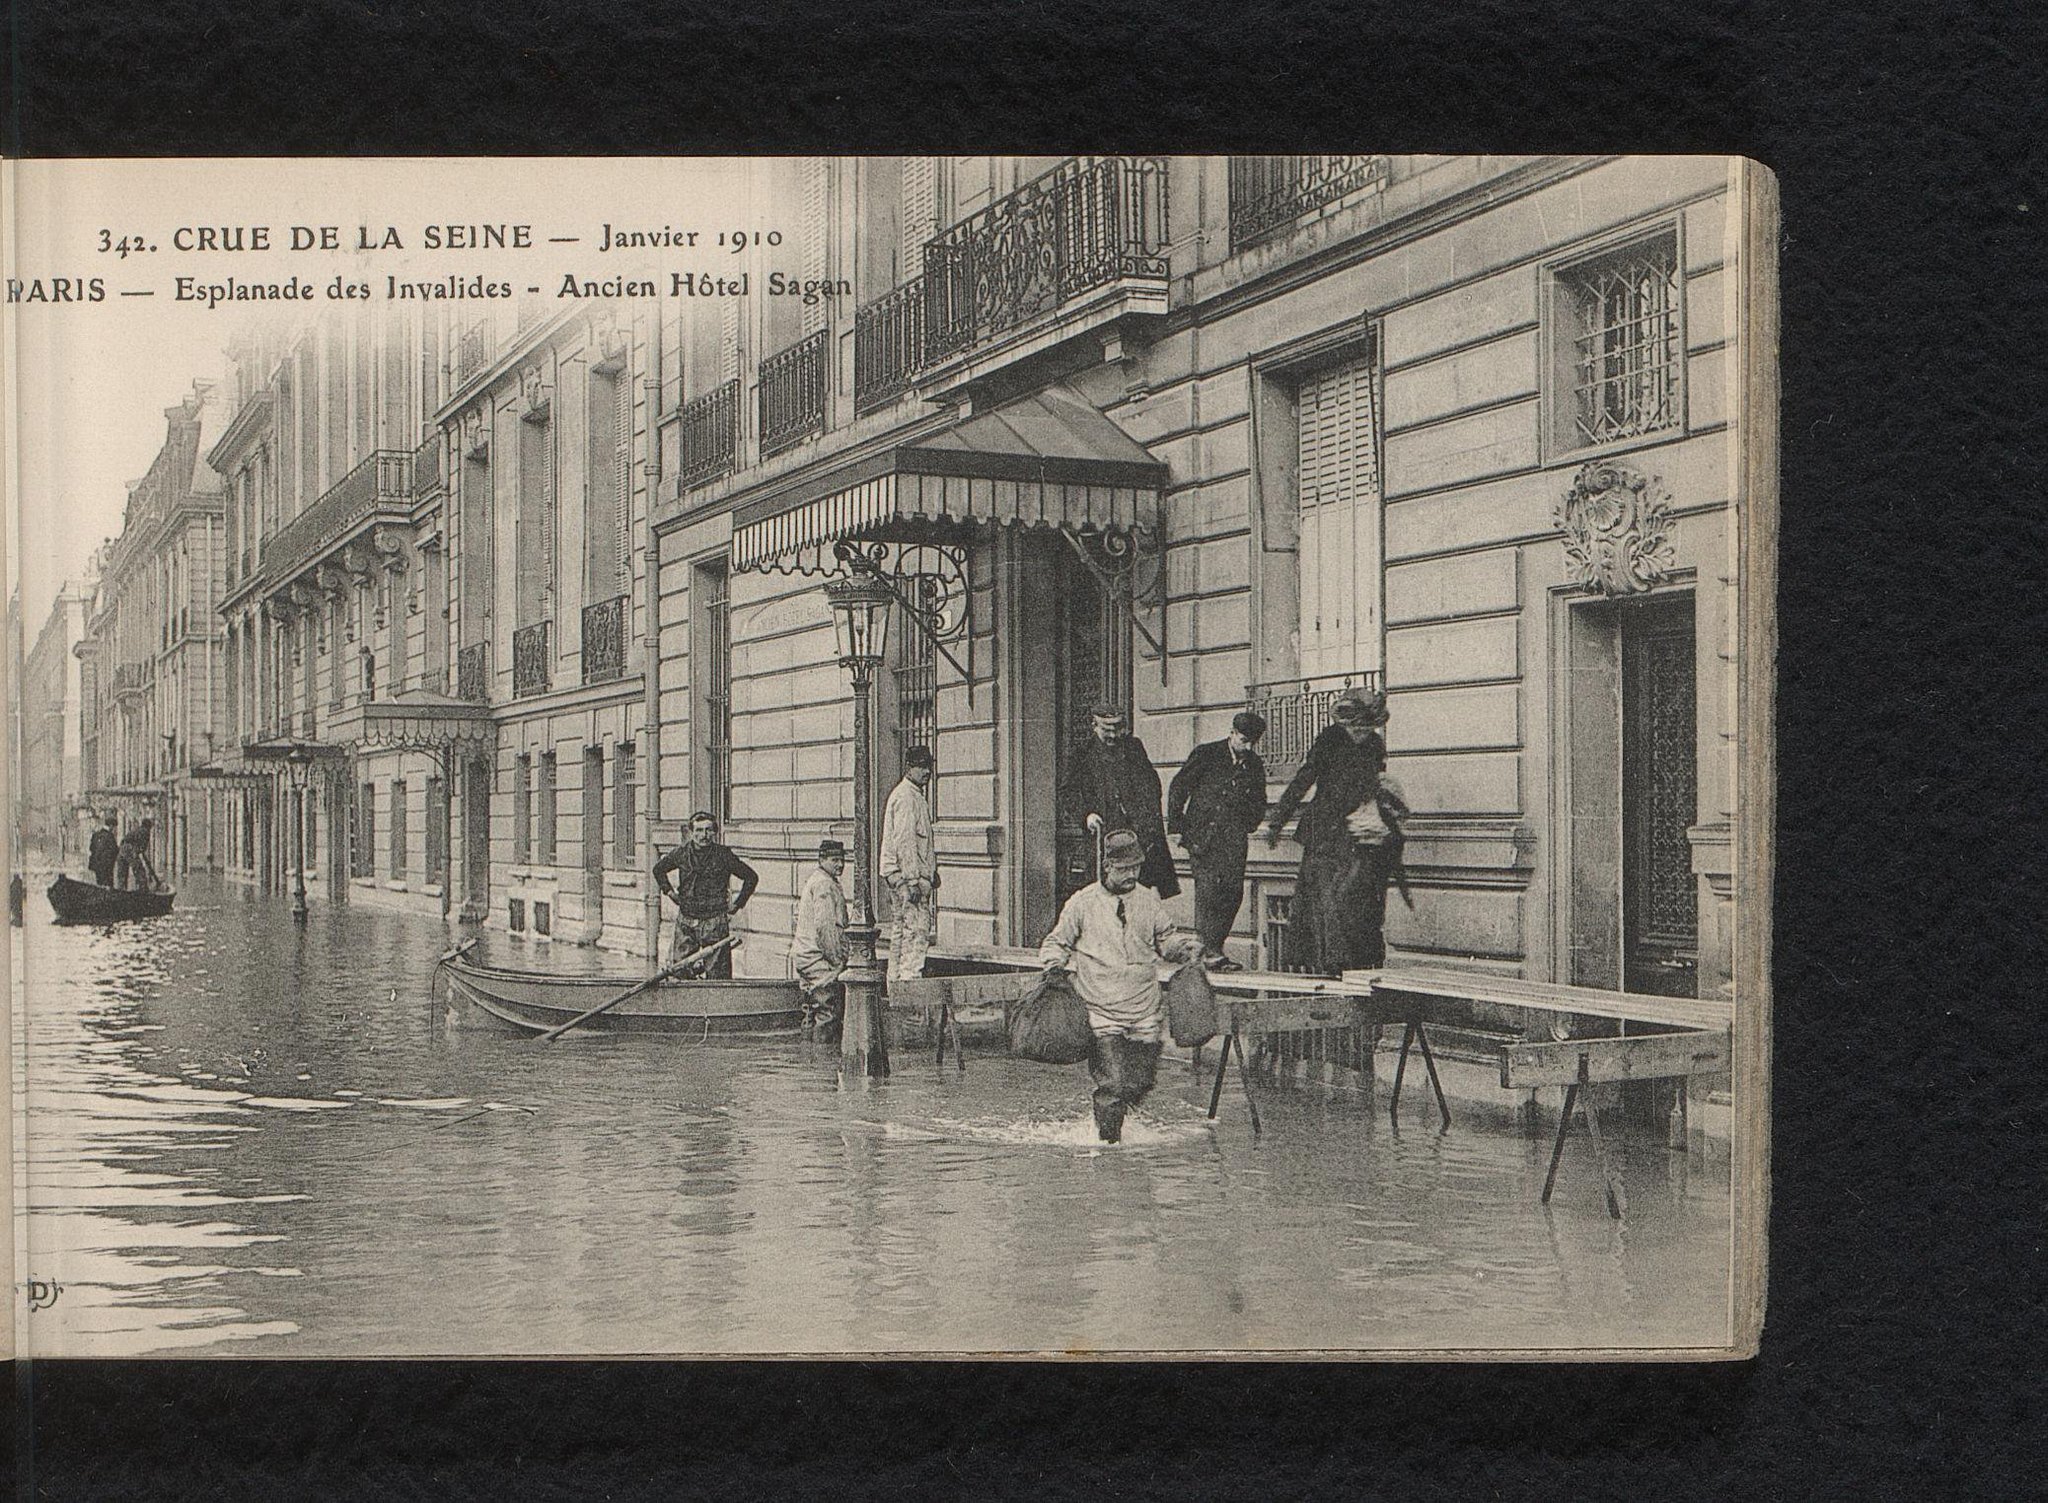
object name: photomechanical print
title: Crue de la Seine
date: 1910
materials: cardboard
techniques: photograph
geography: paris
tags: rowing-boat, canoe, etc., flood, street (+ city(-scape) with figures, staffage), paris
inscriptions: date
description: Prentbriefkaart maakt deel uit van een album.